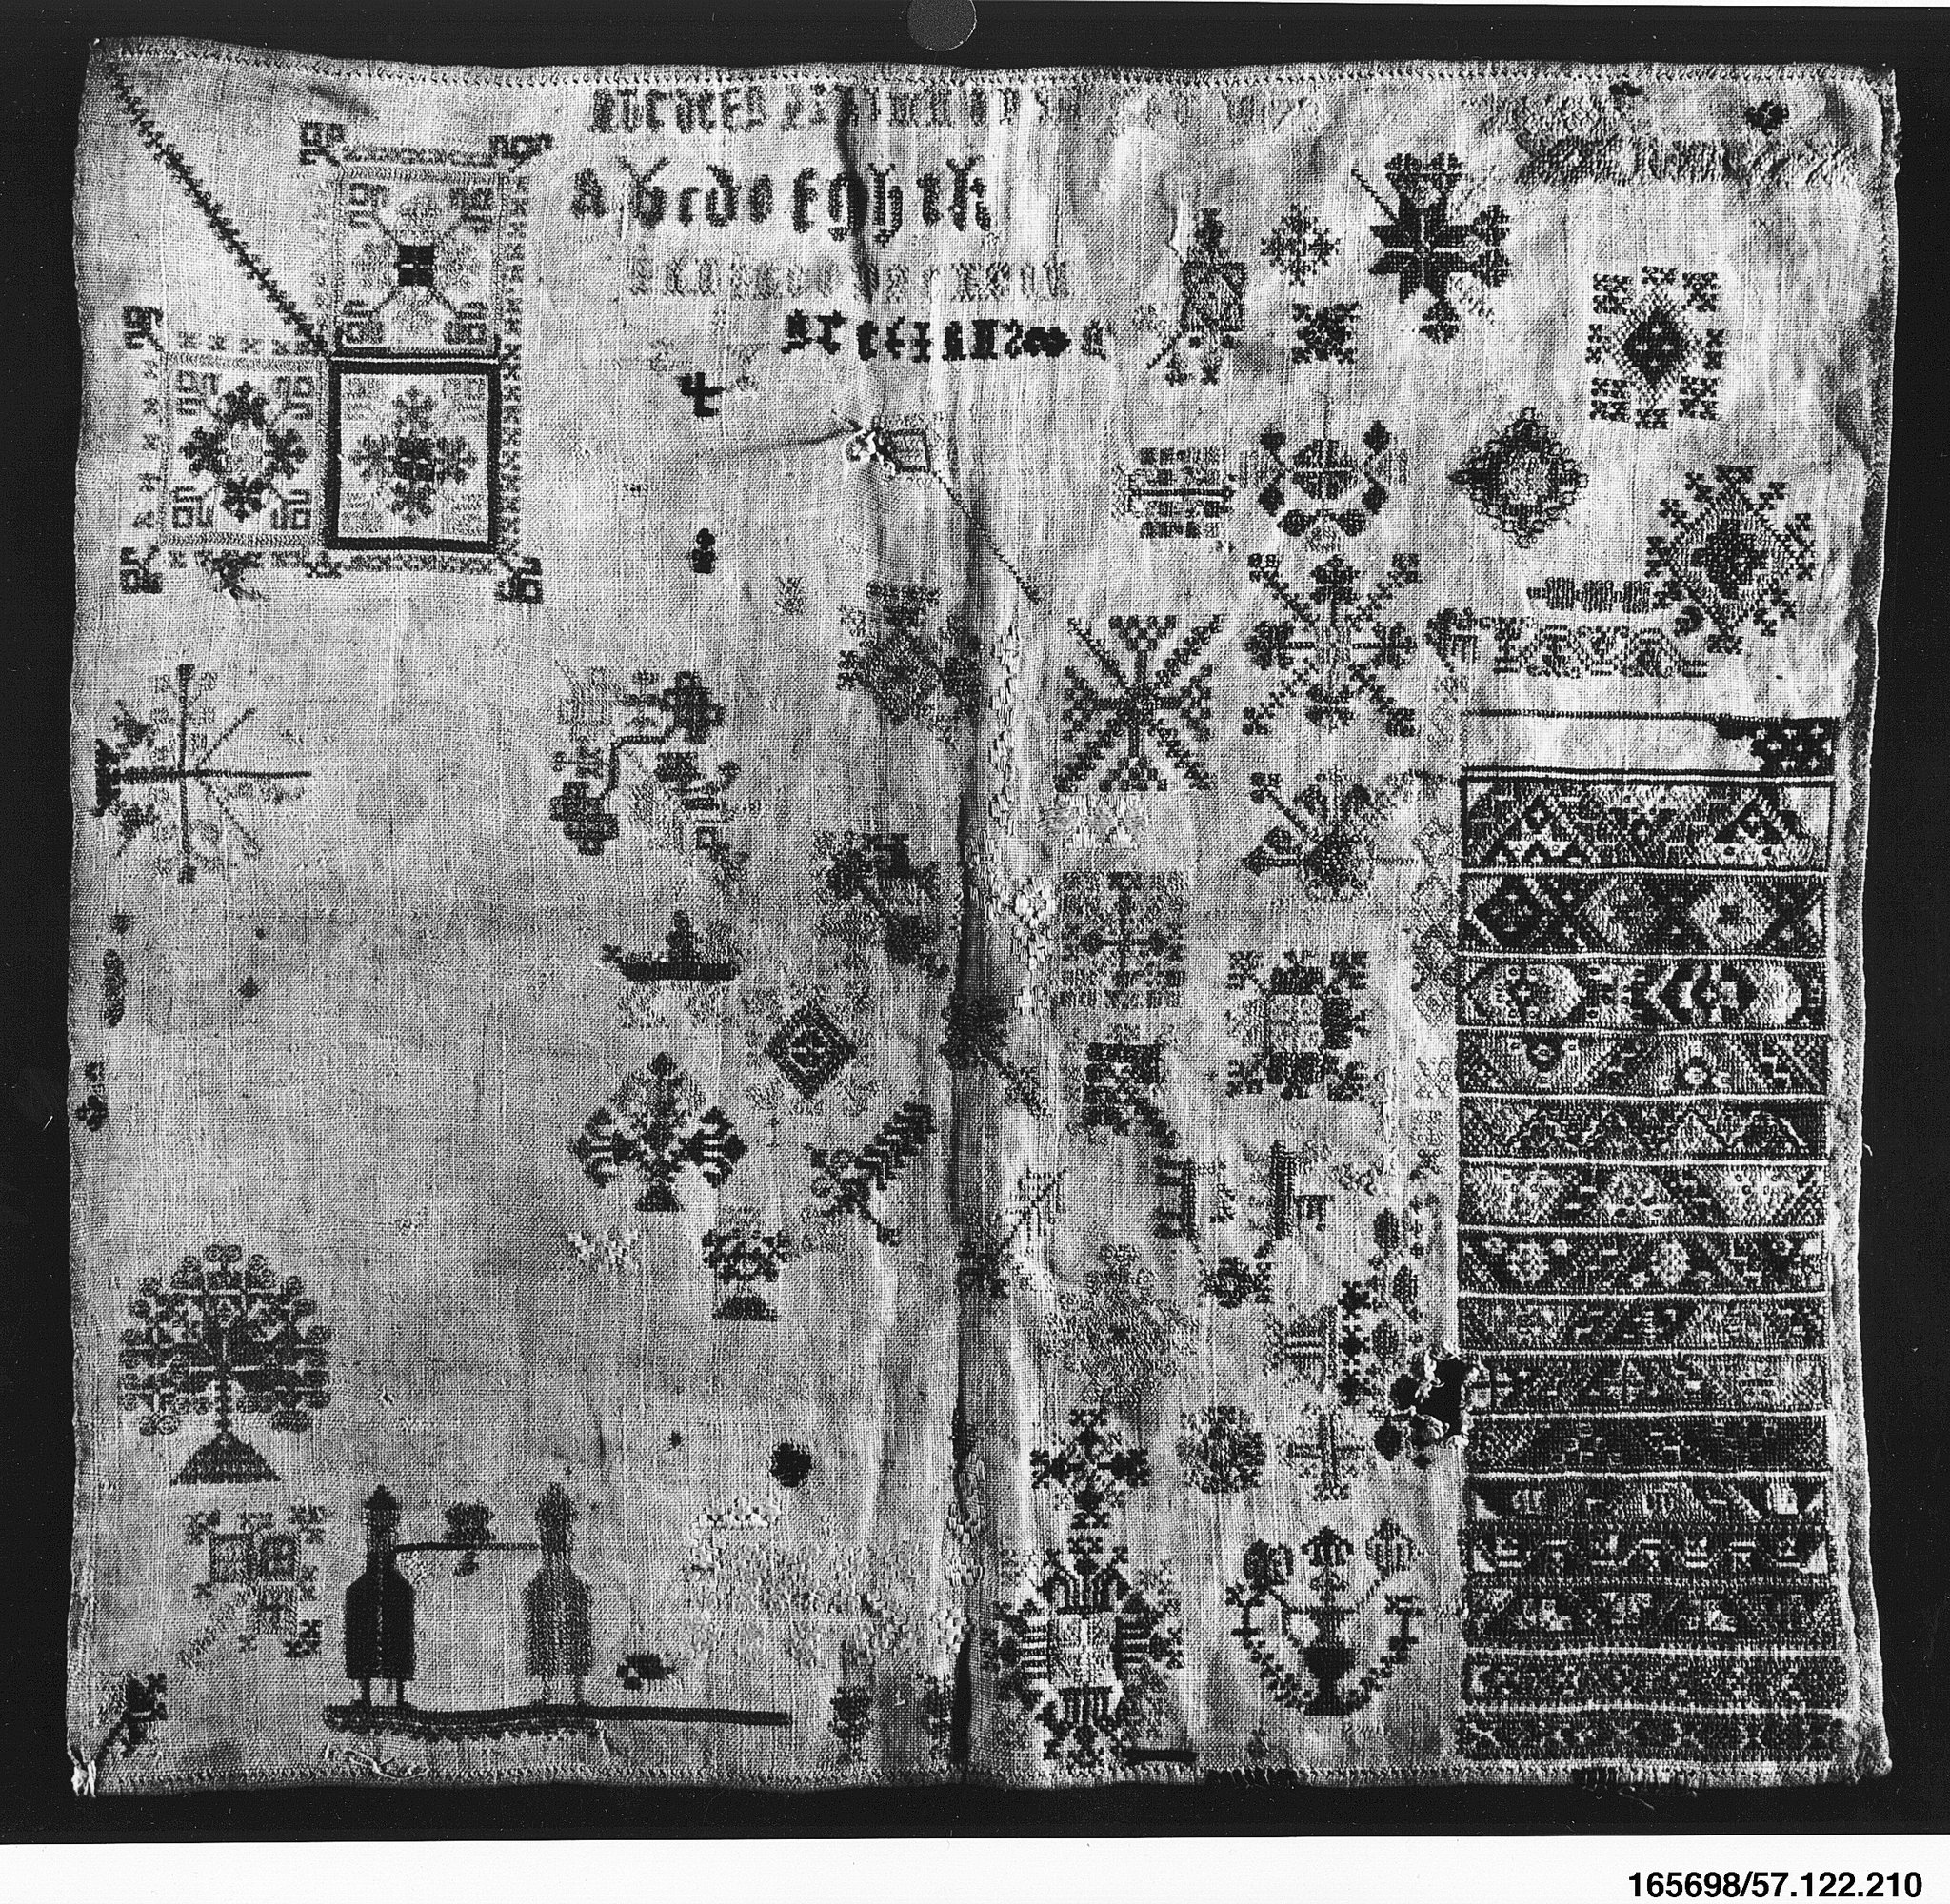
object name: sampler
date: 1730-1739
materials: linen, silk